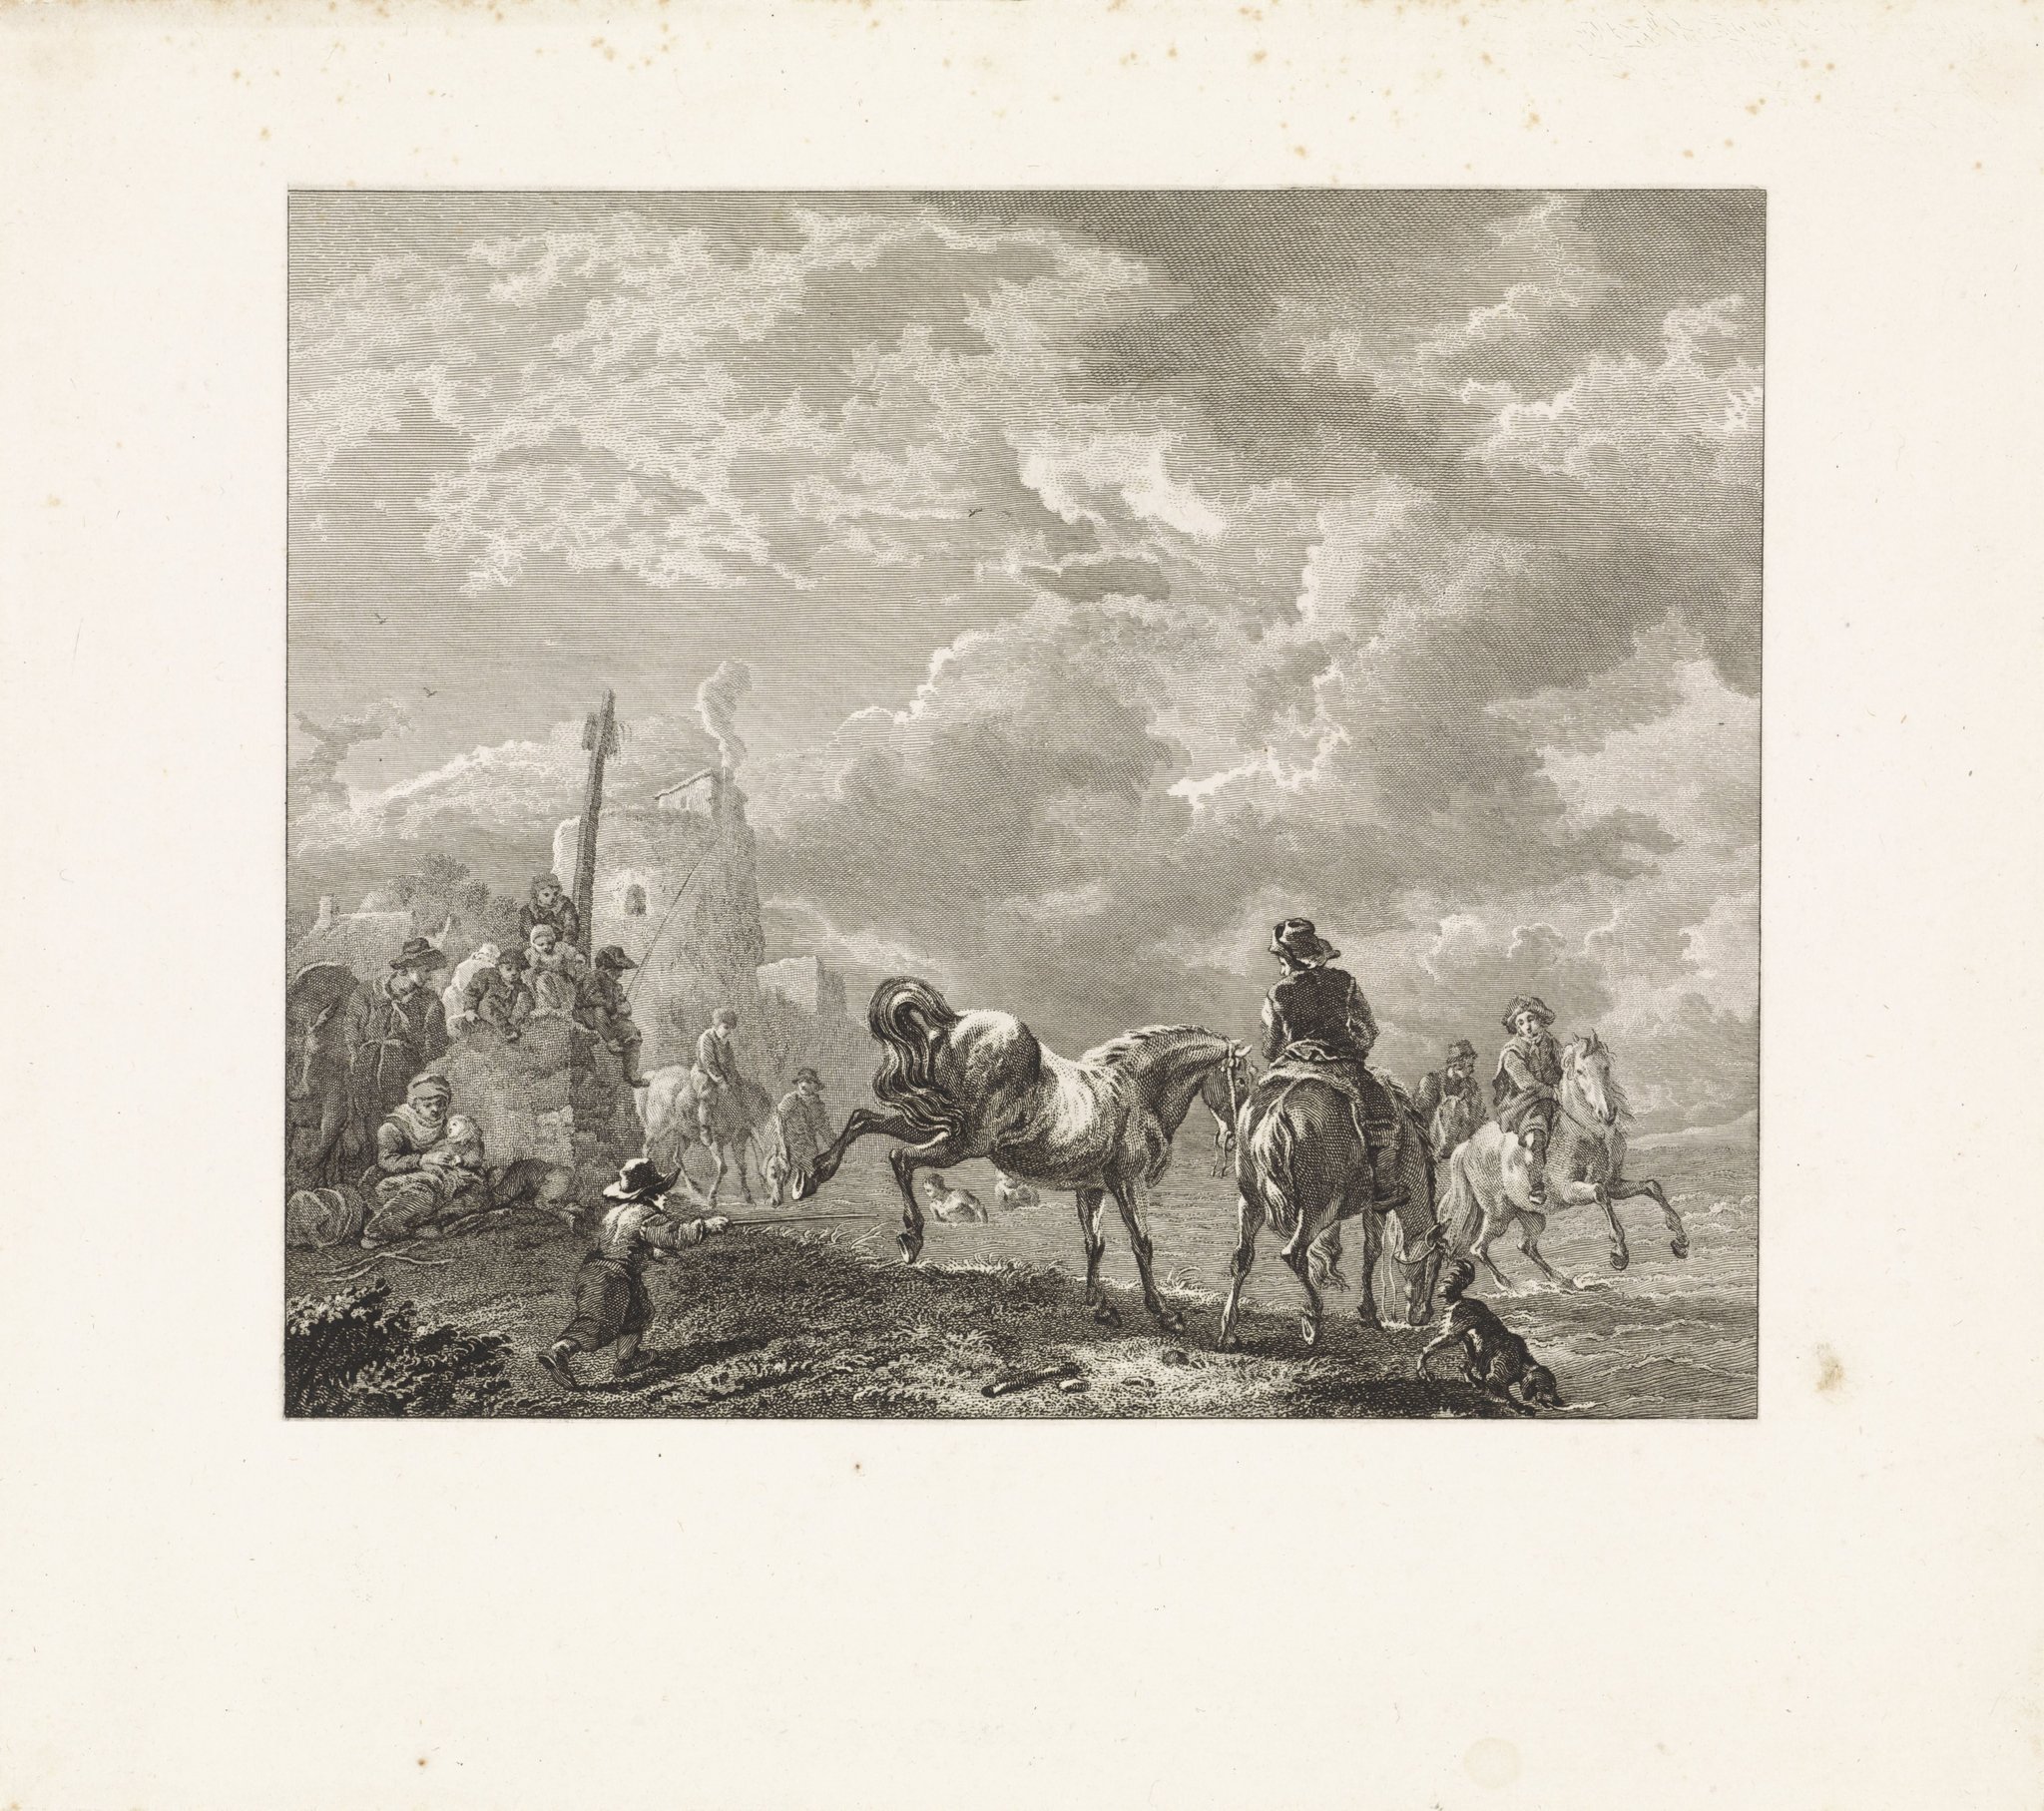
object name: print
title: Paardenwed bij een grenspaal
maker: reinier vinkeles (i)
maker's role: draughtsman, print maker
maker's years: 1741-1816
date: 1805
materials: paper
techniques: engraving, etching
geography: amsterdam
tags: river, horse, dog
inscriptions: collector's mark: Lugt 240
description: Buiten een stad laat een ruiter zijn paard drinken bij een rivier terwijl hij een ander paard aan de toom houdt. In de omgeving andere figuren en ruiters. In de rivier baden enkele figuren, bij de grenspaal zit een jongen met een hengel.